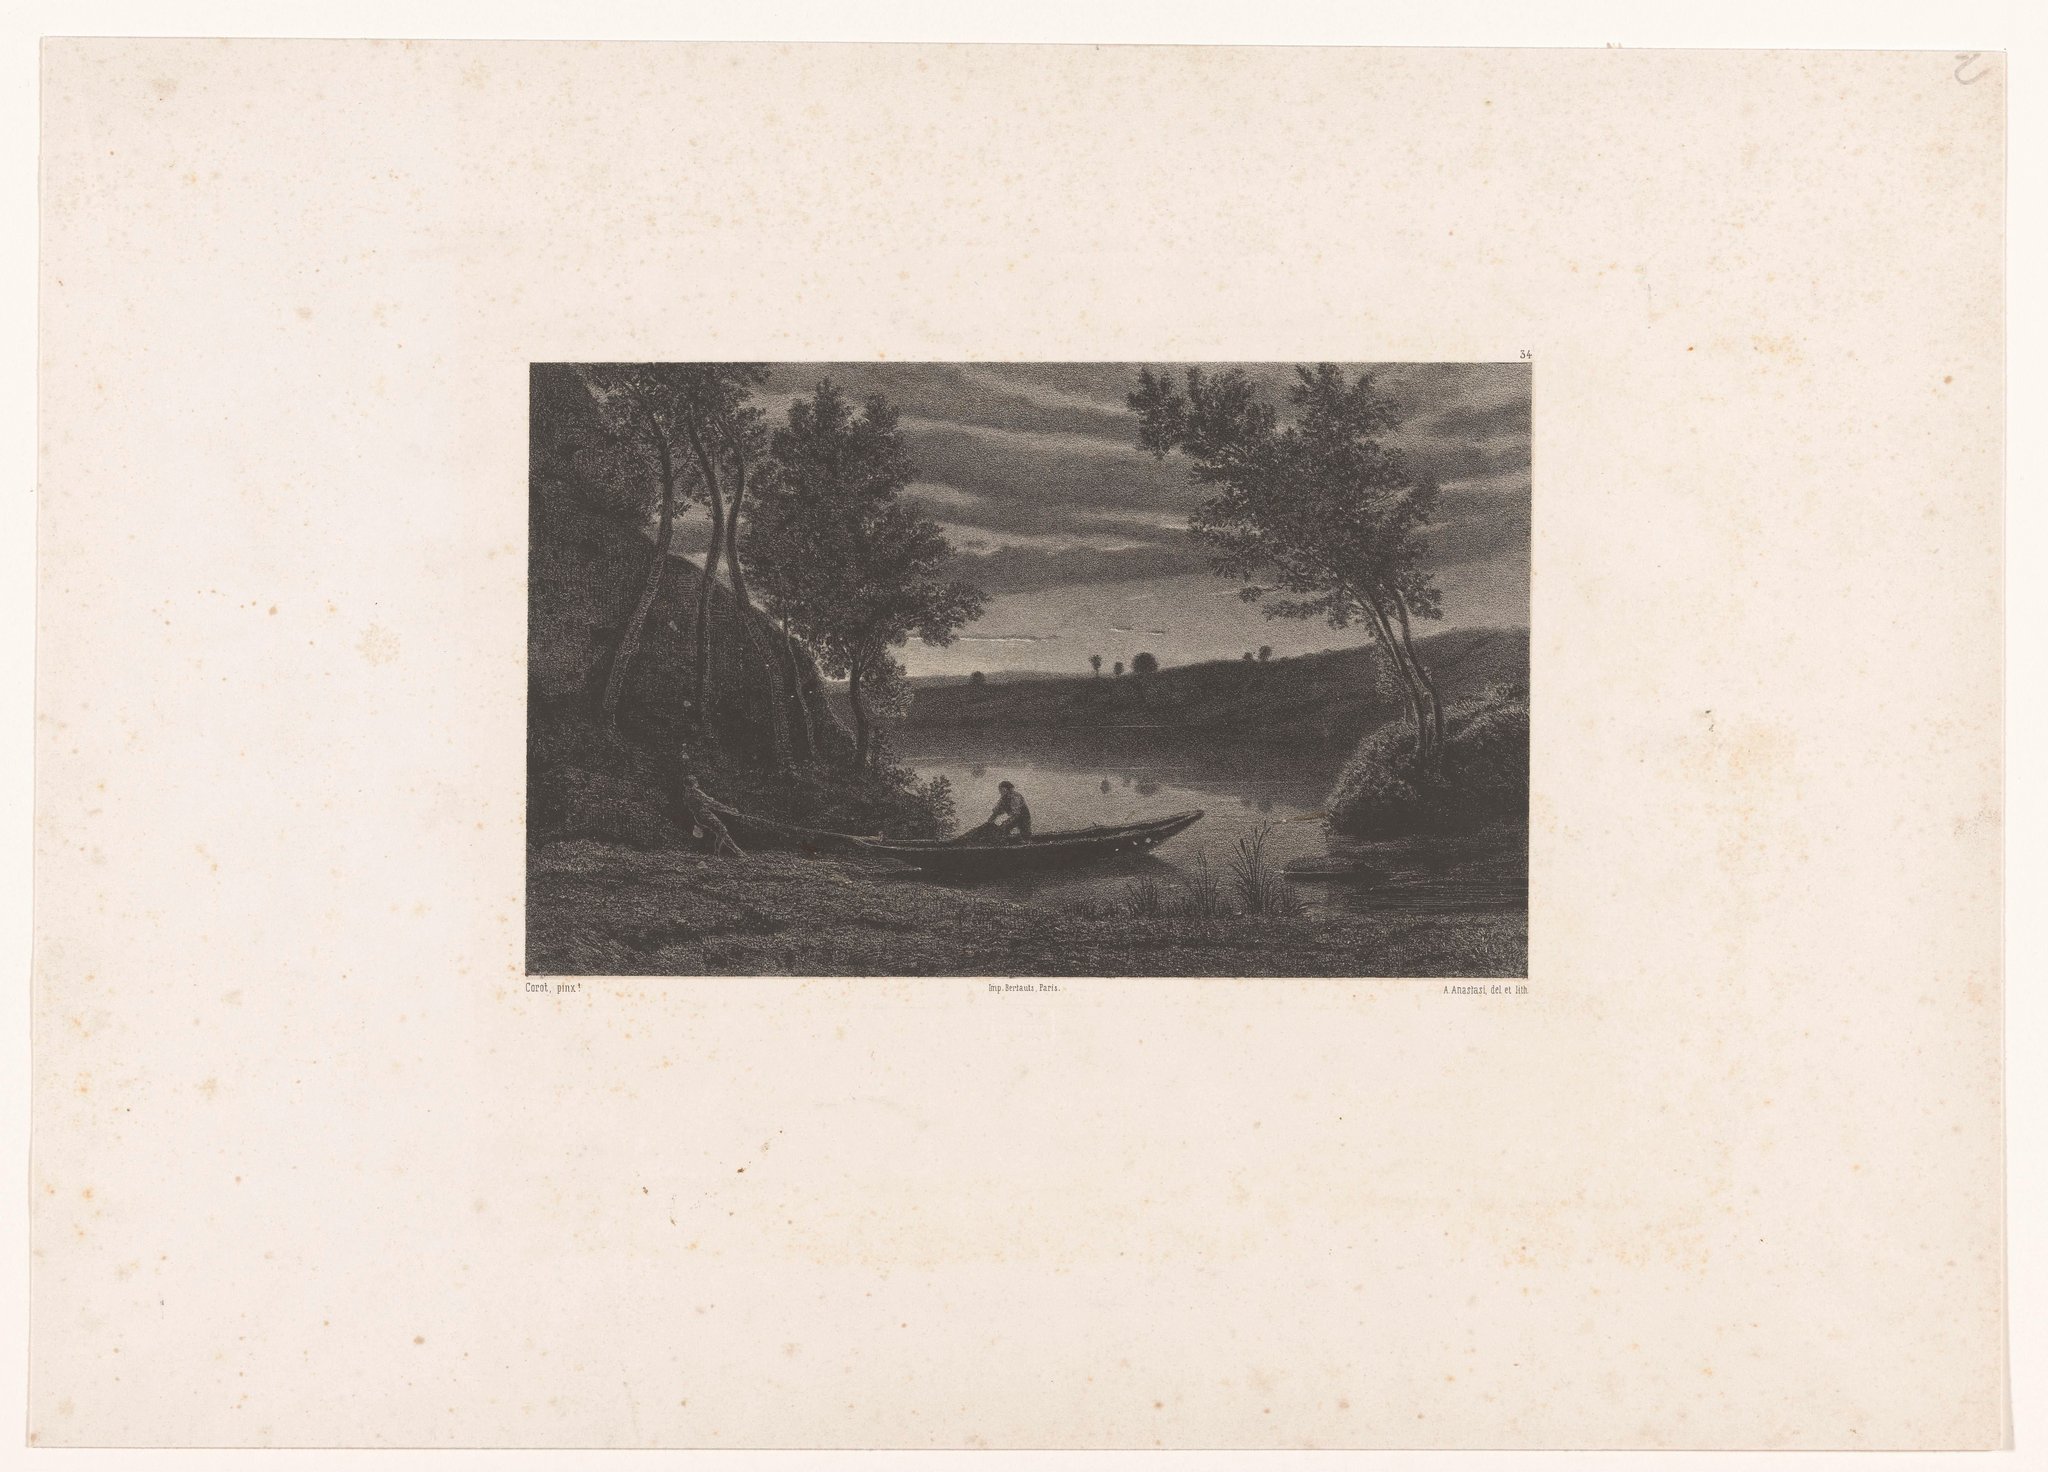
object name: print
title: Rivierlandschap met vissers bij avond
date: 1847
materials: paper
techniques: lithograph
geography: paris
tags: river, rowing-boat, canoe, etc., evening ~ landscape (sometimes titled 'vesper'), fisherman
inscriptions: collector's mark: Lugt 2228, check stamp: Lugt 36b